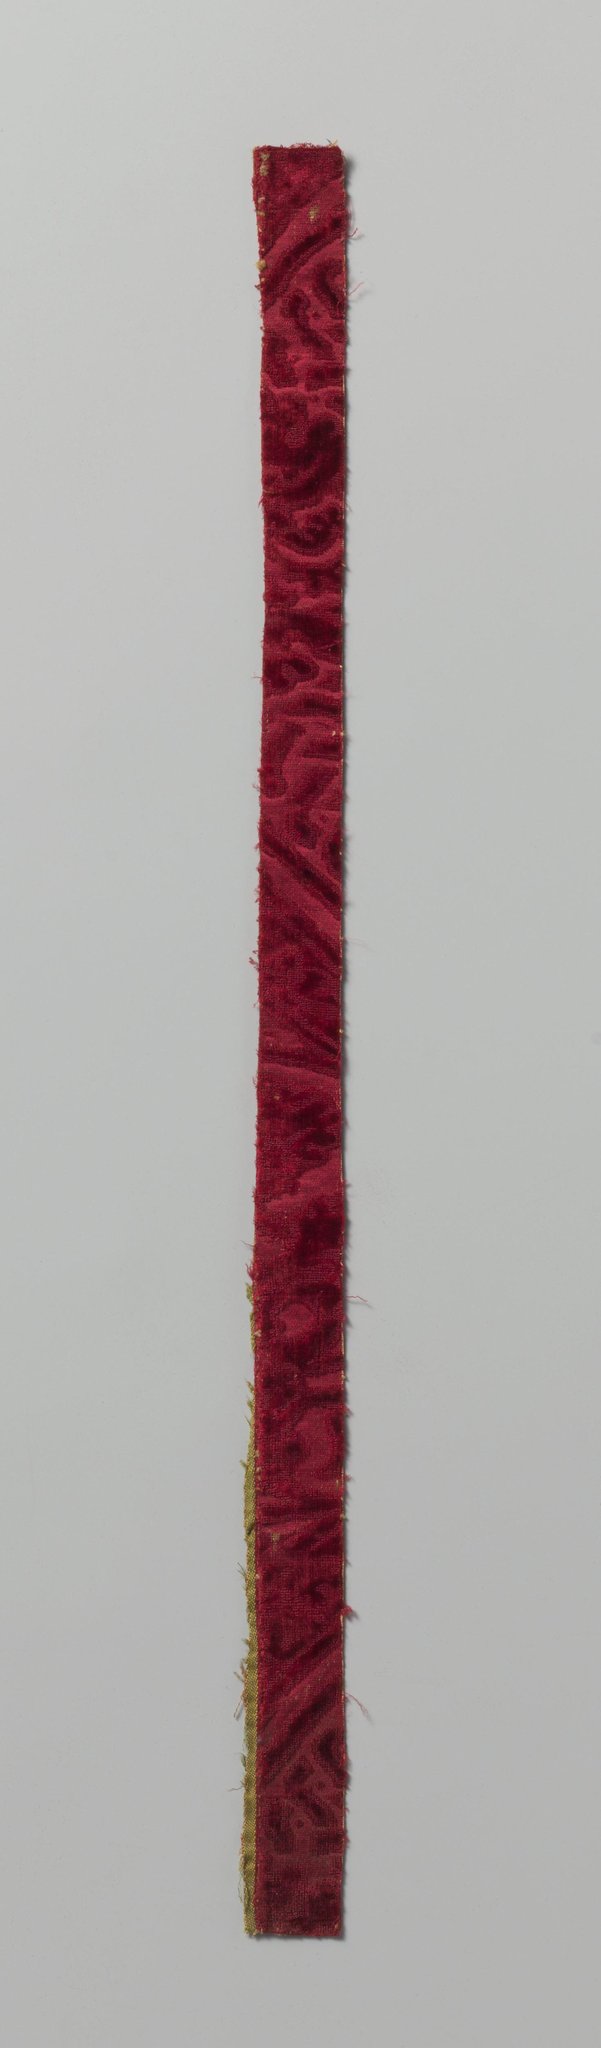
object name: zijdefluweel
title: Fragment donkerrode zijdefluweel met uitsparingen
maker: Anonymous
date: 1500-1599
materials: silk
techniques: velvet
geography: genoa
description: Fragment donkerrode fluweel met patroon van dubbel omkranste bloem, waarvan de buitenste kransen zijn samengeknoopt.